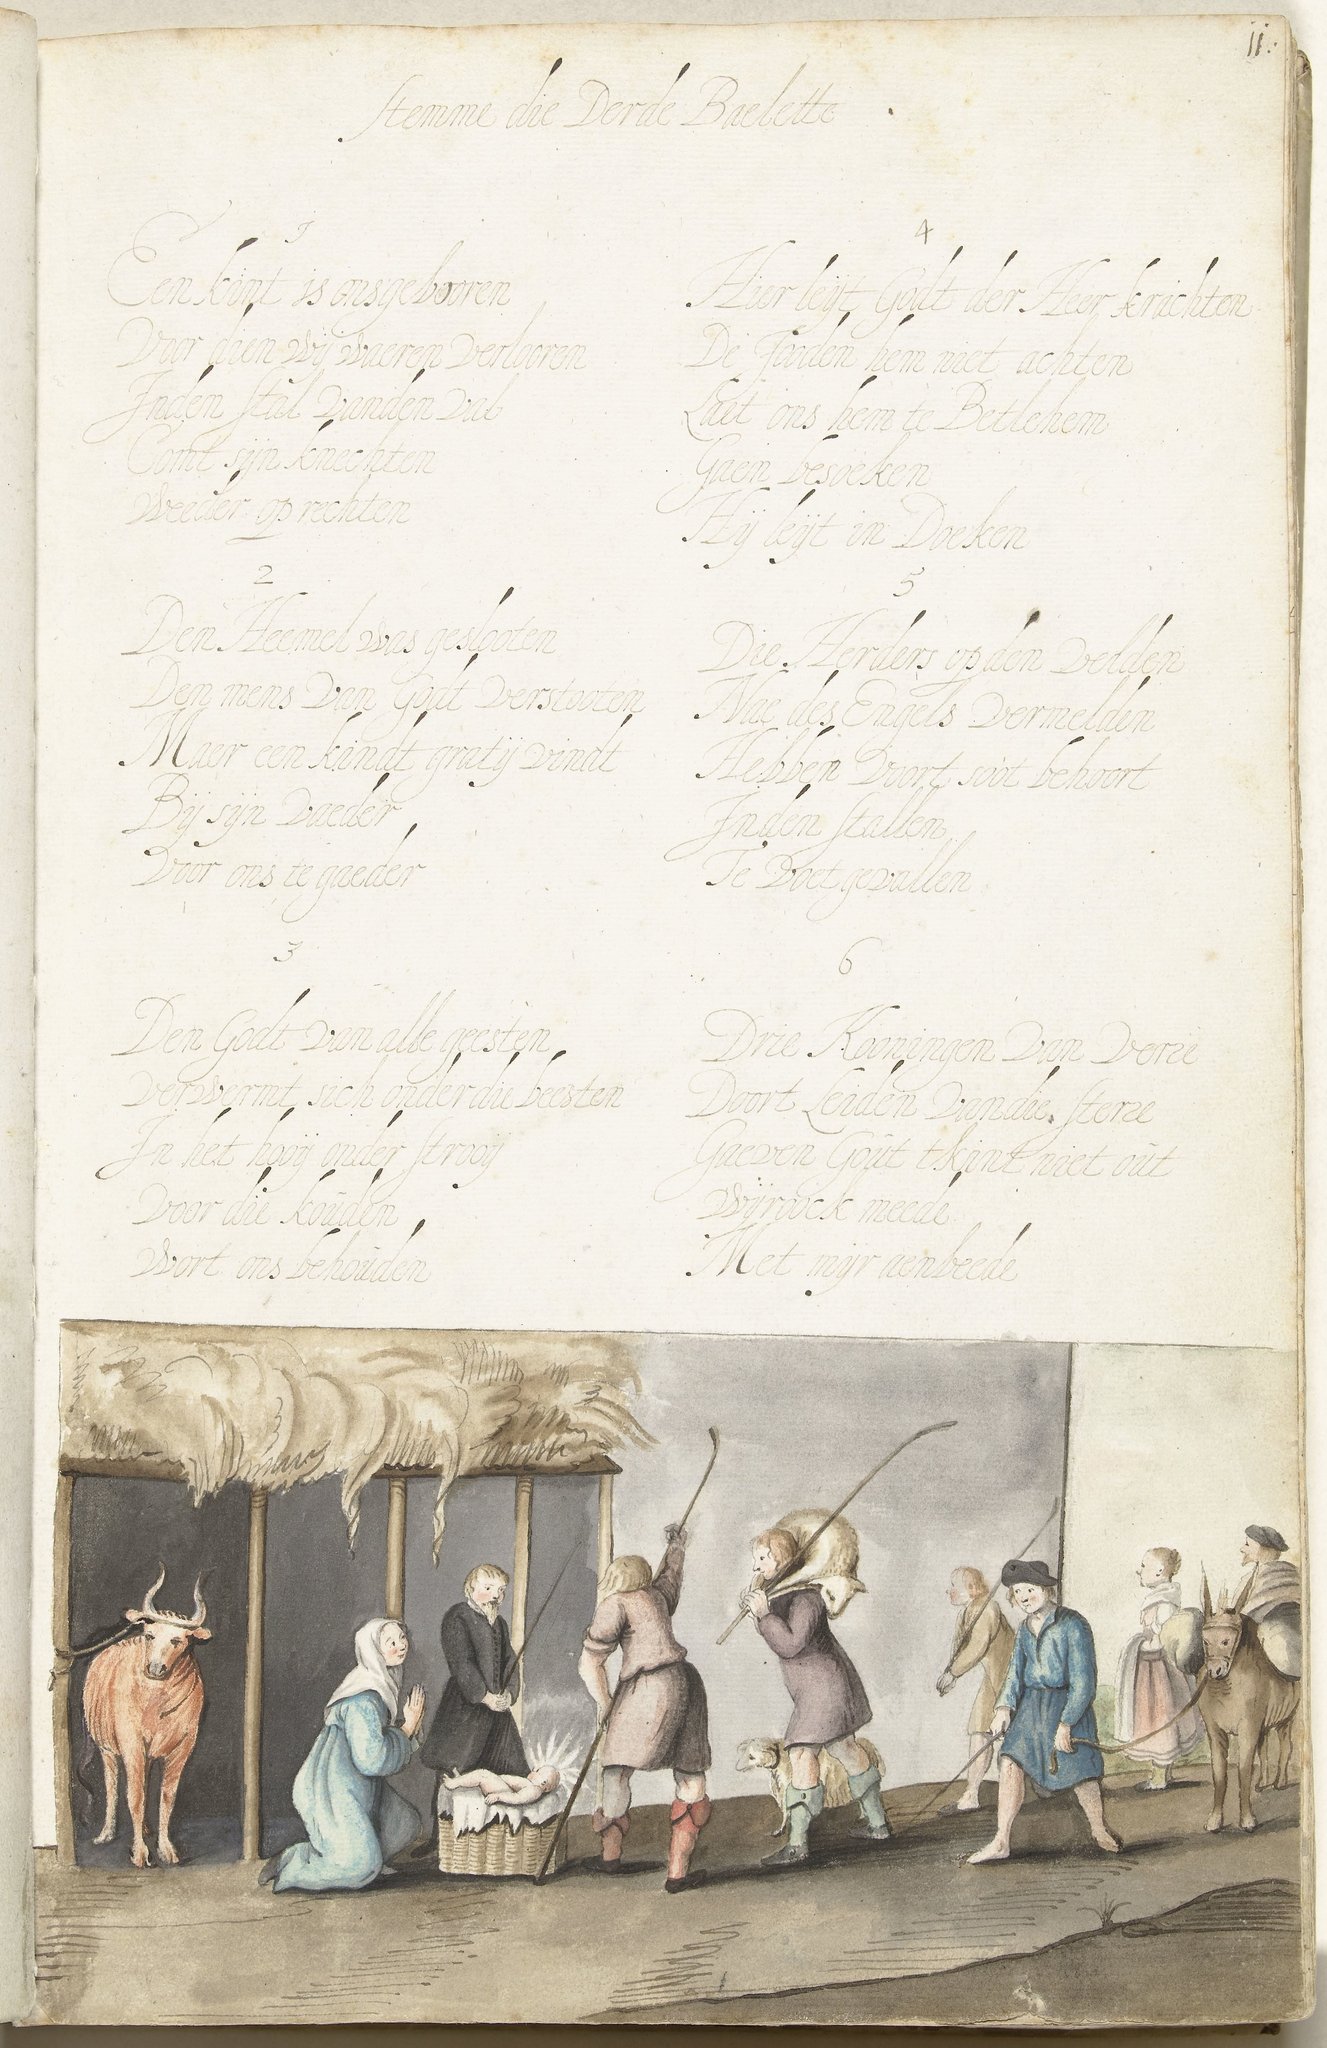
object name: calligraphy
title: Aanbidding der herders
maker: gesina ter borch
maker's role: draughtsman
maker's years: 1633-1690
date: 1612-1652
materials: ink, paper, watercolor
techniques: brush, calligraphy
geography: zwolle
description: Aanbidding der herders onder kerstlied op de melodie van Die Derde Baelette, zes coupletten.